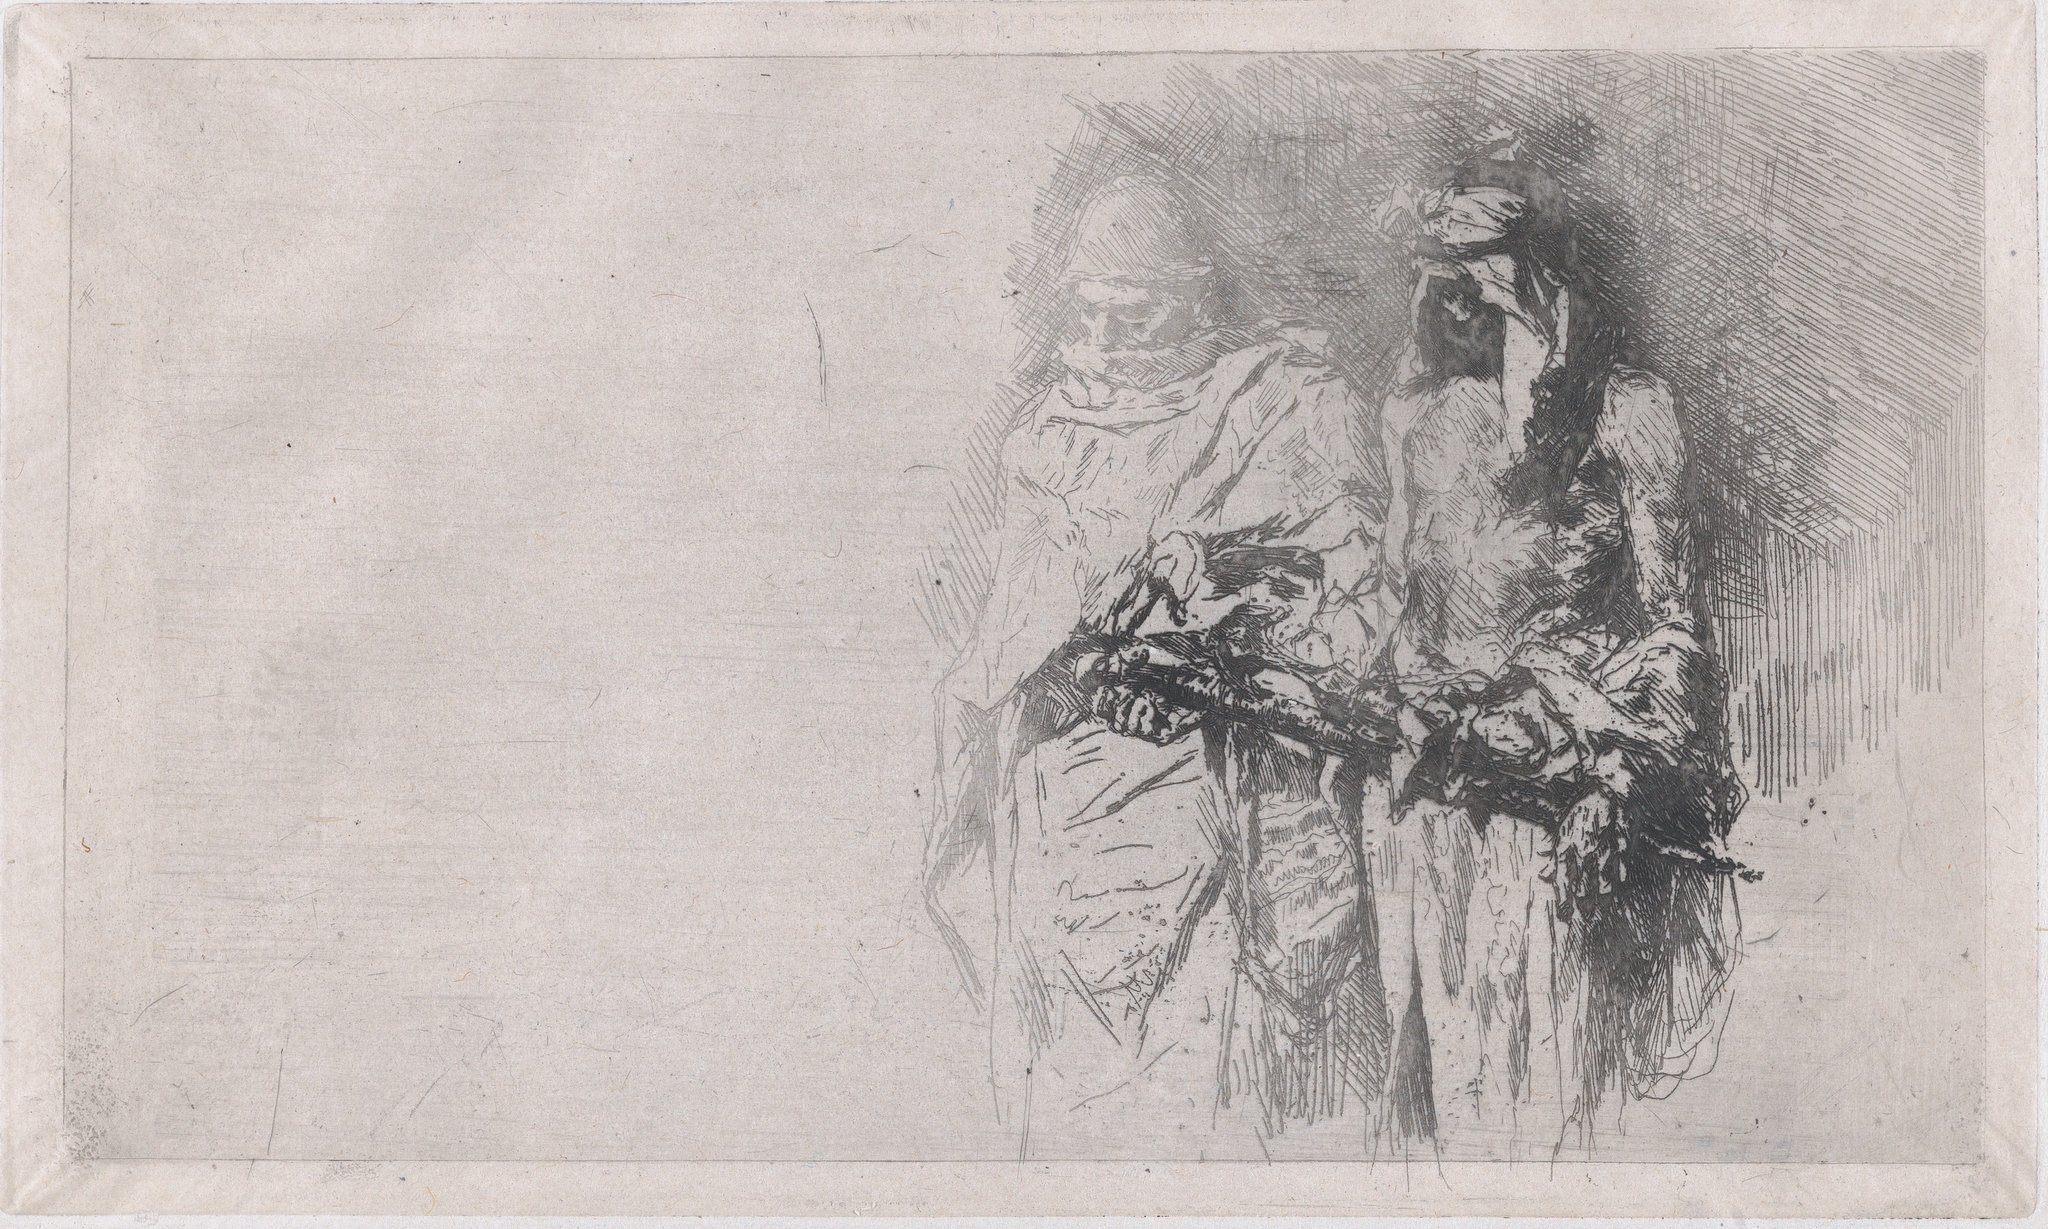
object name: print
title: Croquis (sketch) of two Arabic men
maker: mariano fortuny, 1838–1874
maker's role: artist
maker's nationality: spanish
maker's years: 1838-1874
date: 1860-1870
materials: paper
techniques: etching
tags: men